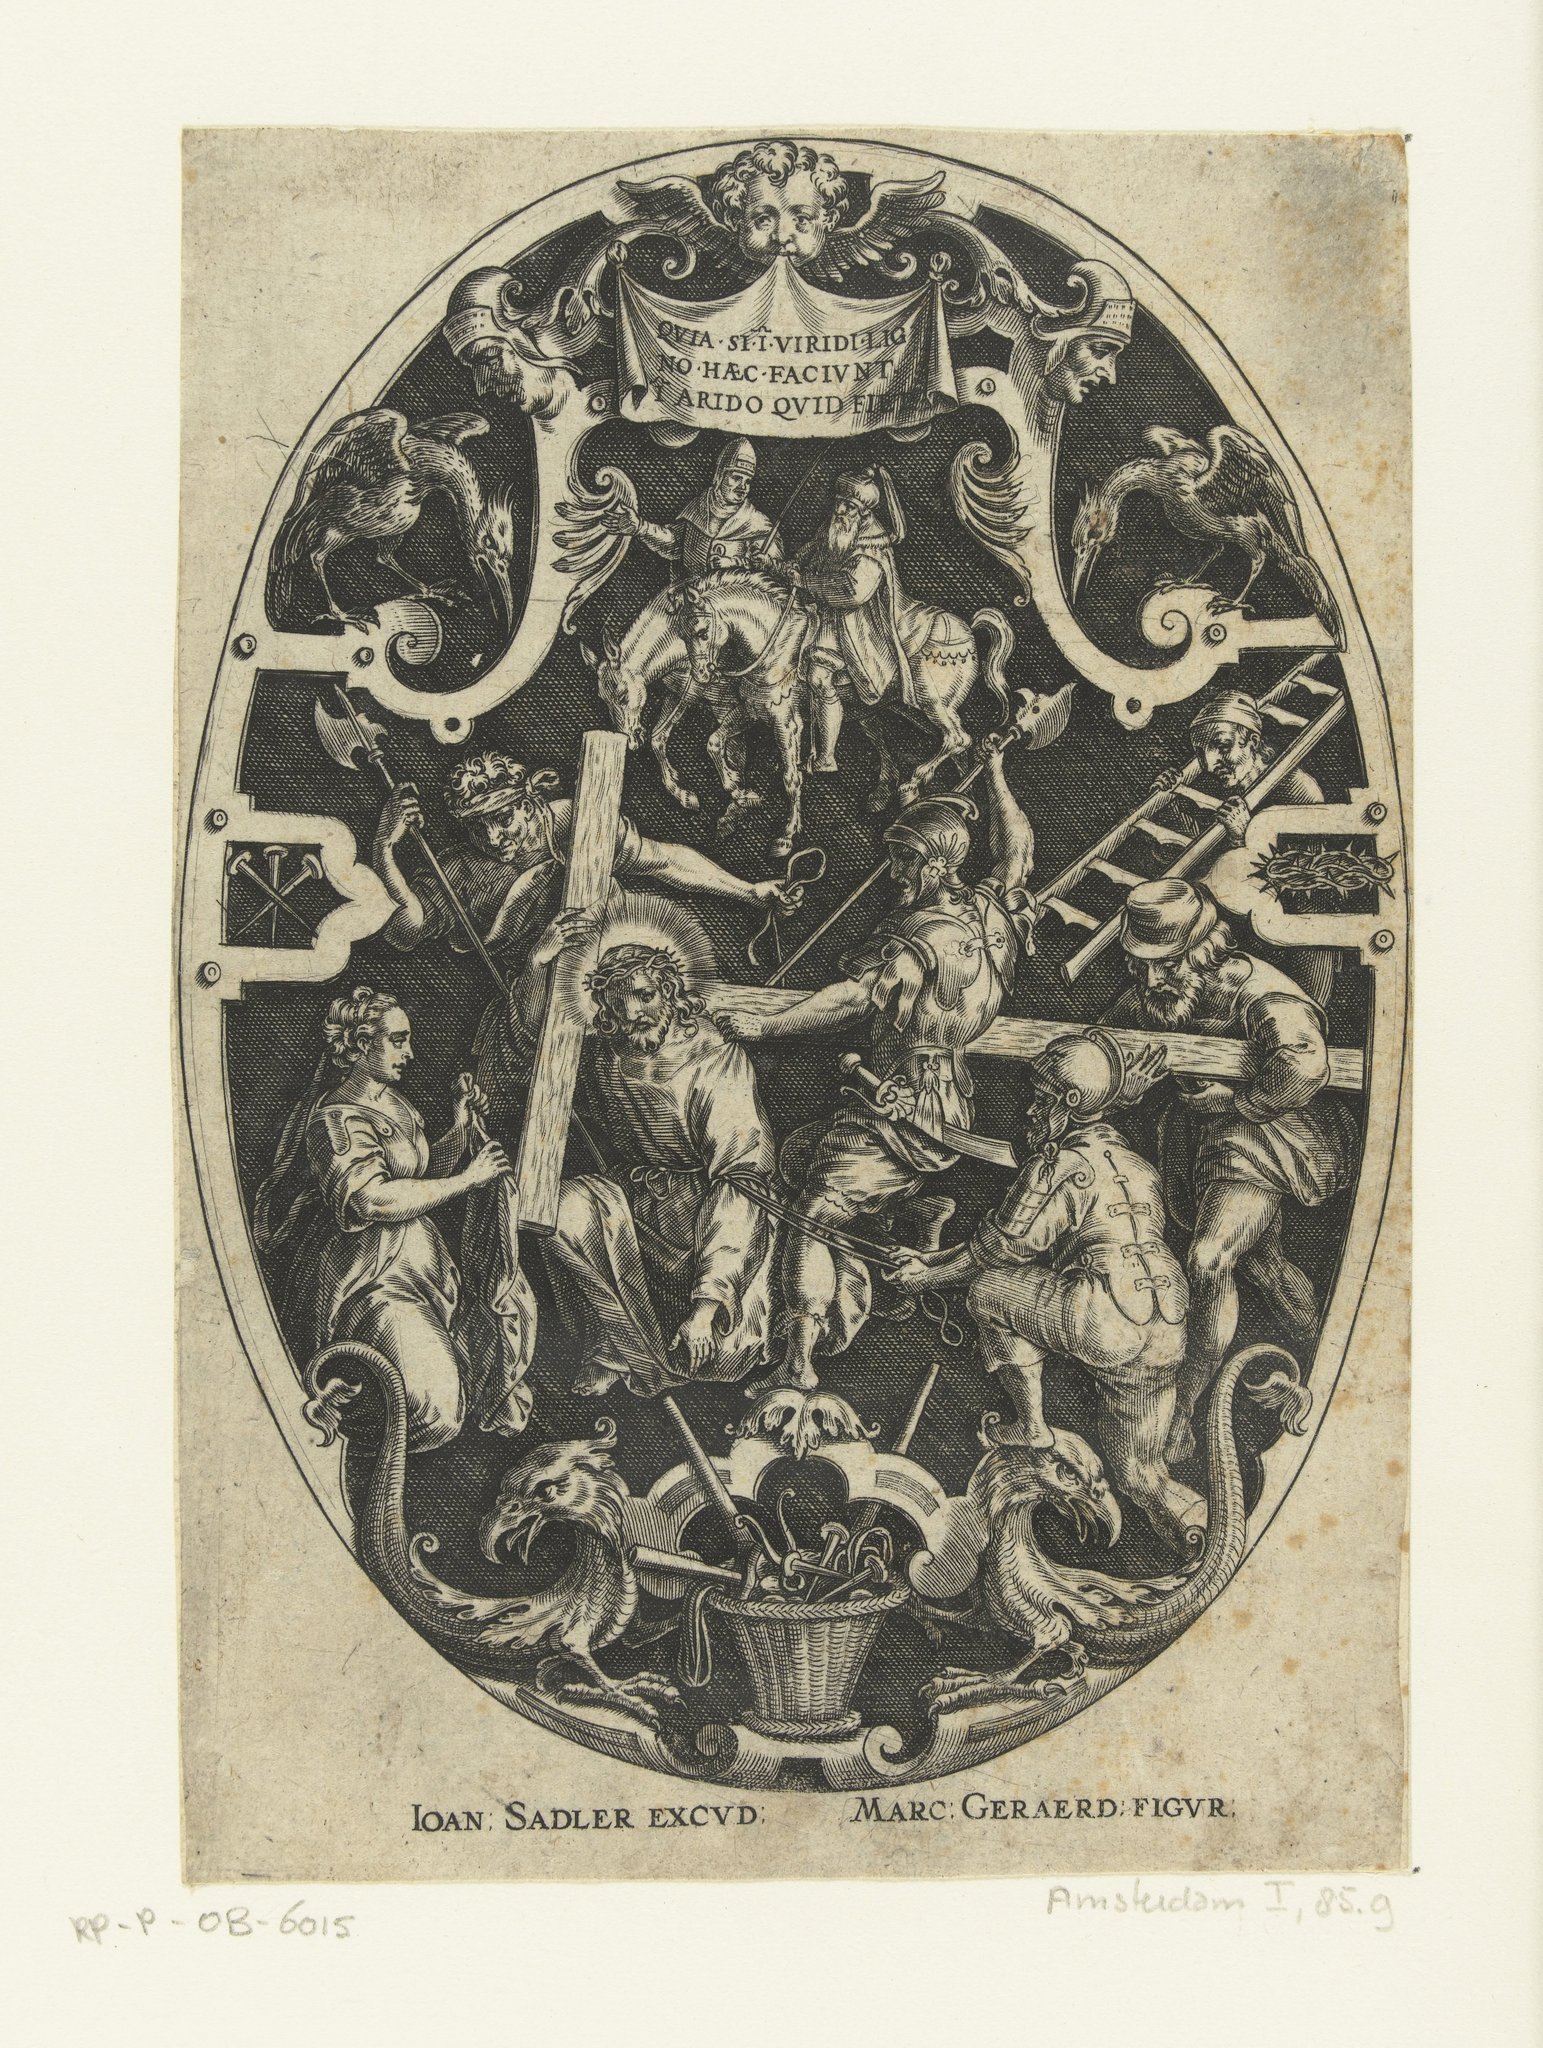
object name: ornament print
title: Passio verbigenae quae redeptio Christ (...)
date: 1560-1600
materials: paper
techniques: engraving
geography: netherlands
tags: christ meets veronica, who has a cloth to wipe christ's face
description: Christus draagt het kruis en ontmoet Veronica. Uit serie van 14 ovalen met grotesken waarin scènes uit de passie zijn afgebeeld. Gearceerde achtergrond.